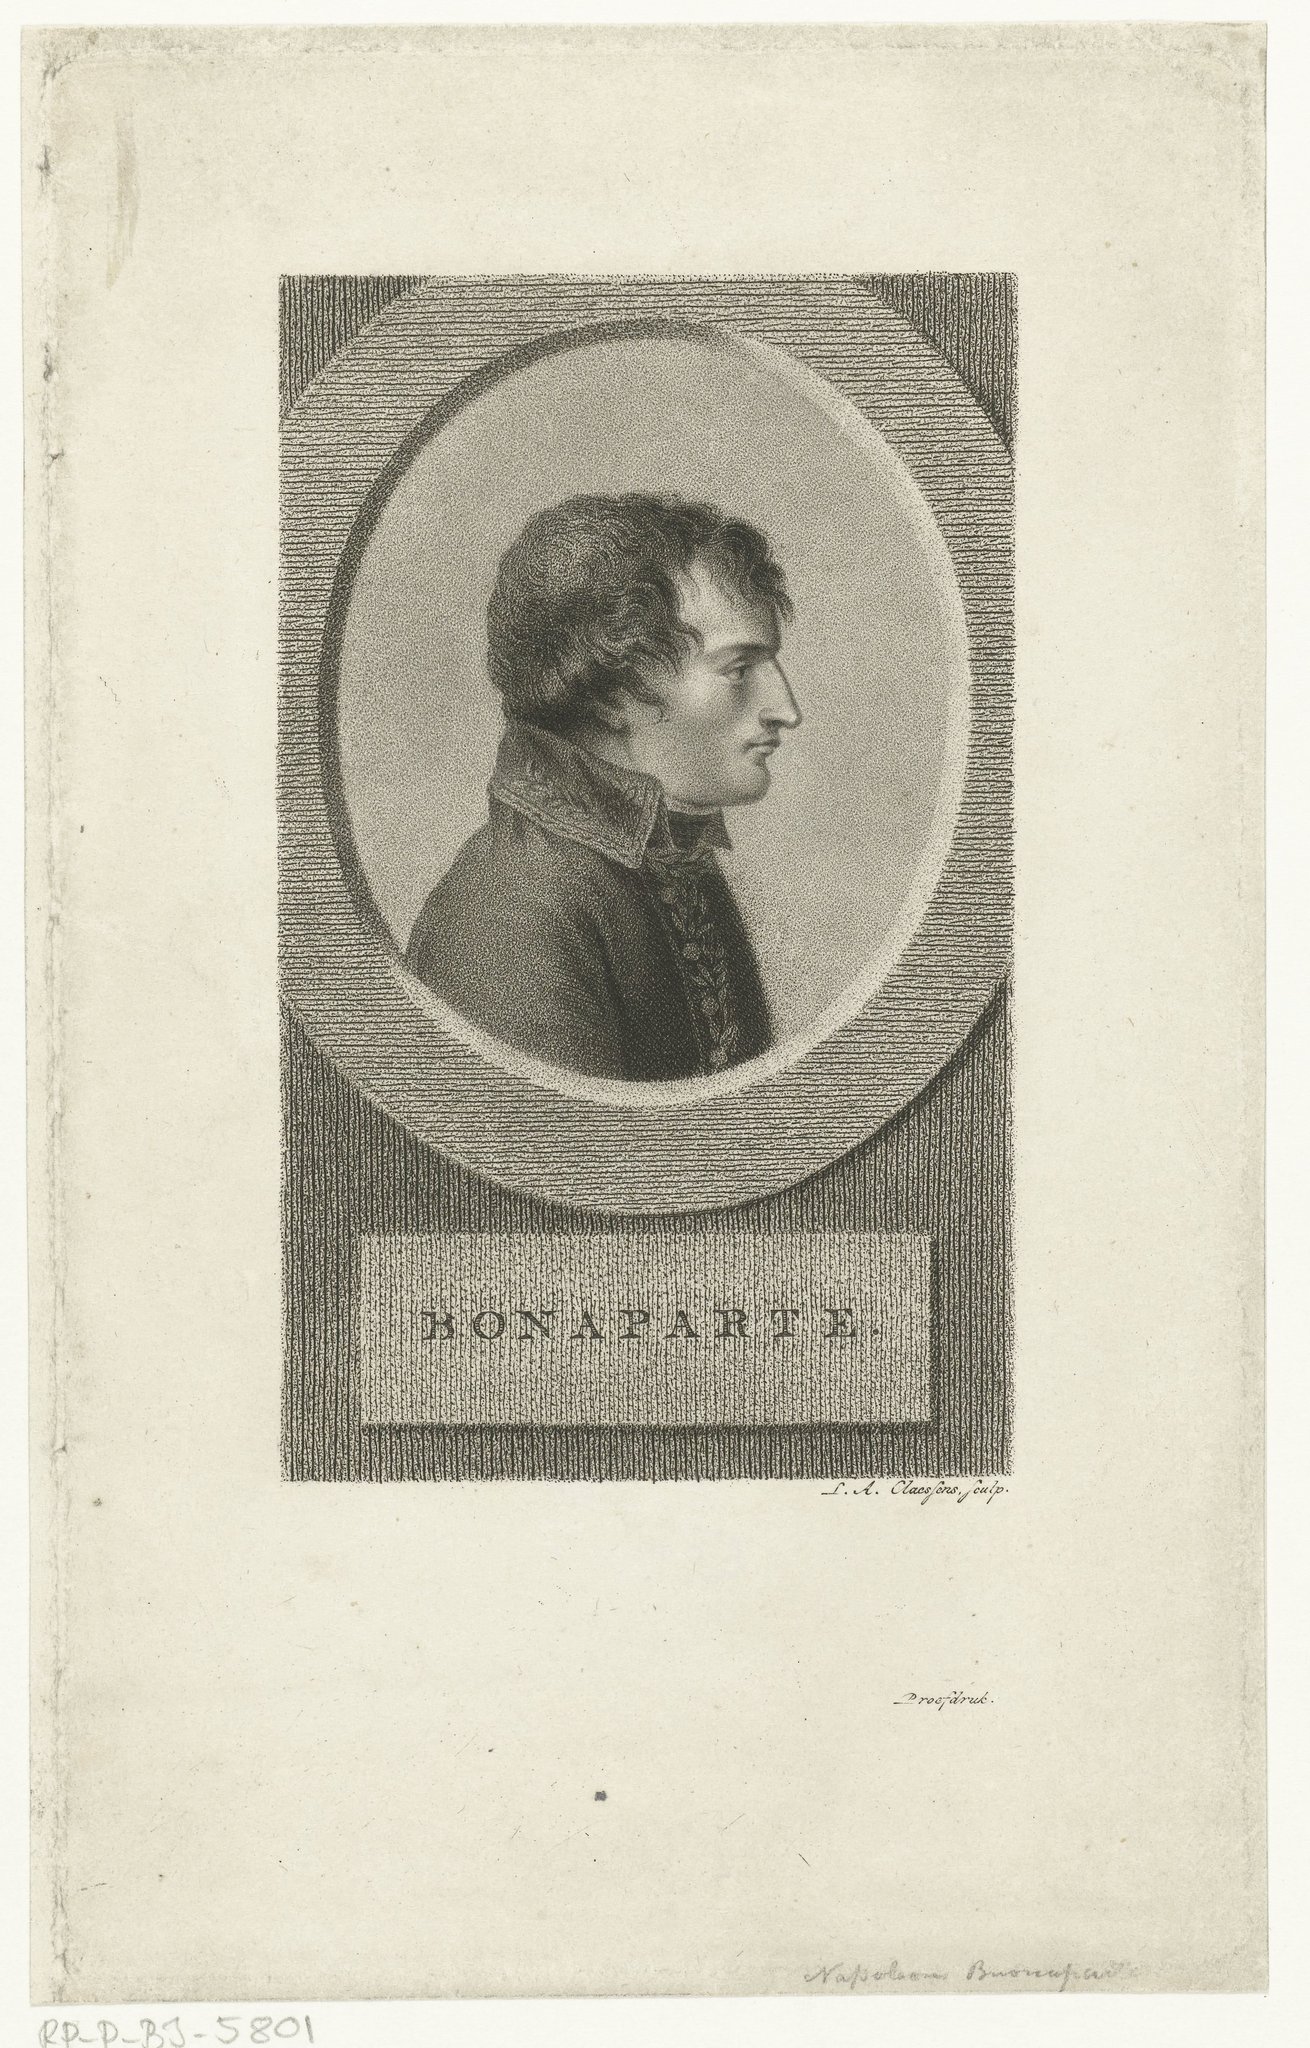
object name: print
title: Portret van Napoleon Bonaparte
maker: lambertus antonius claessens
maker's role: draughtsman, print maker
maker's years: 1763-1834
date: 1792-1808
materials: paper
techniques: engraving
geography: amsterdam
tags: napoleon i (emperor of the french)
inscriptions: collector's mark: Lugt 2228